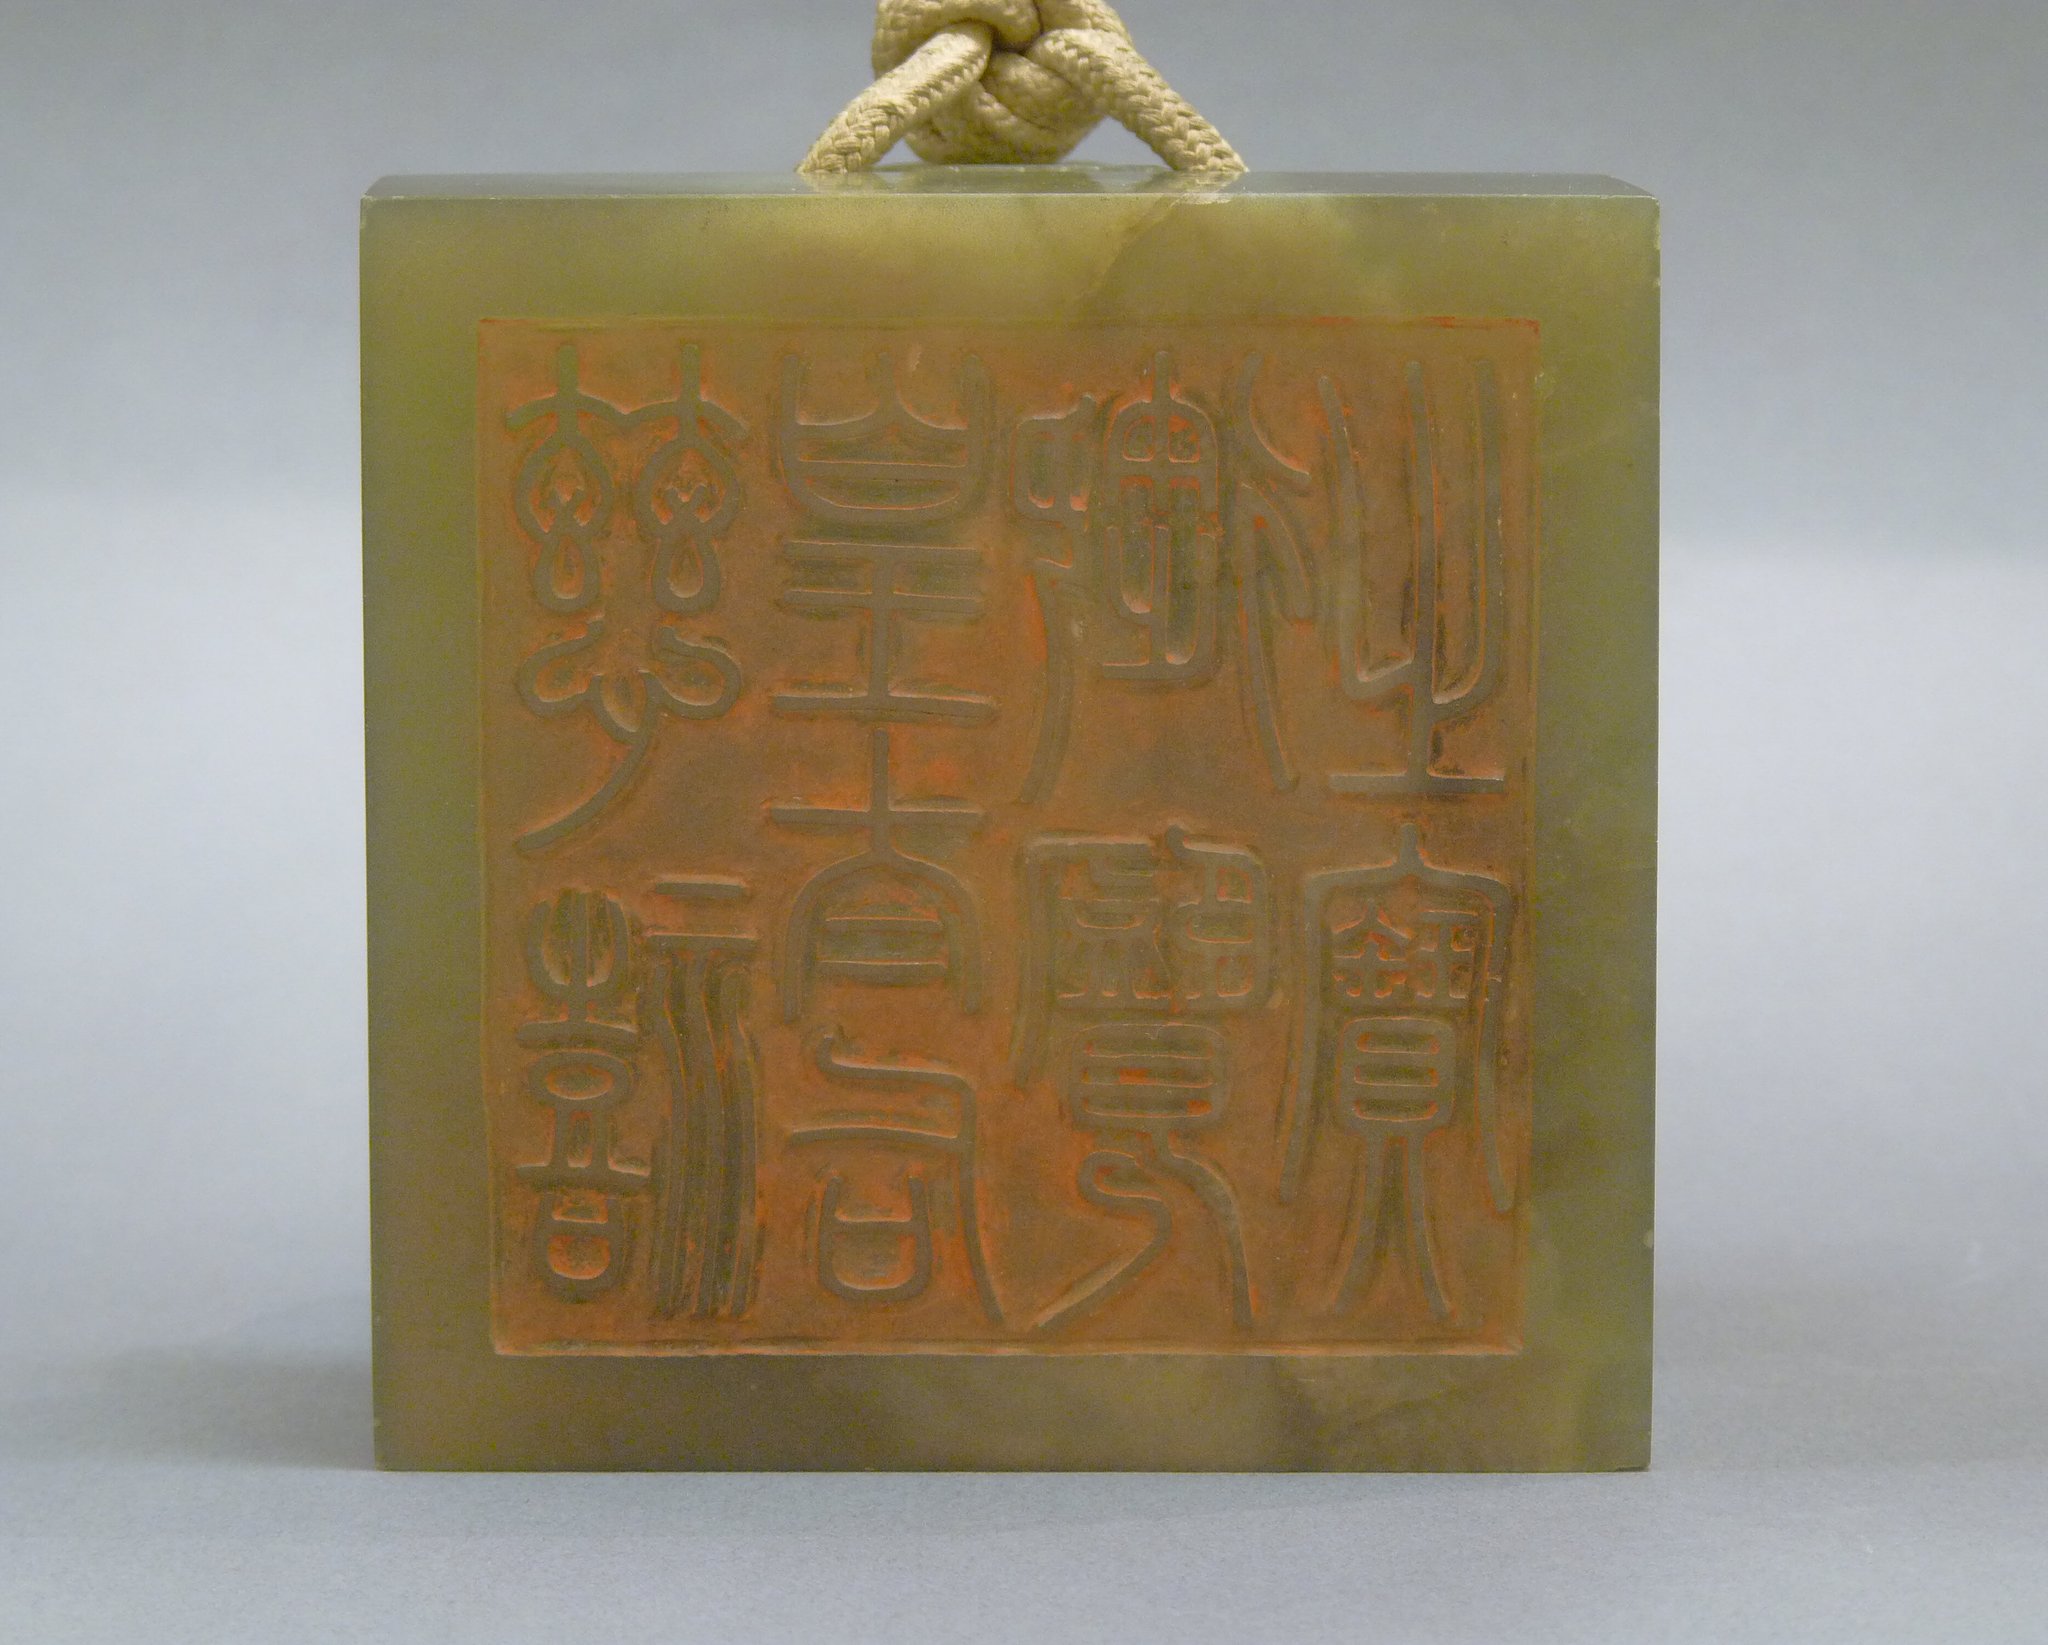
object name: seal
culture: chinese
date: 1801-1900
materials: jade, silk